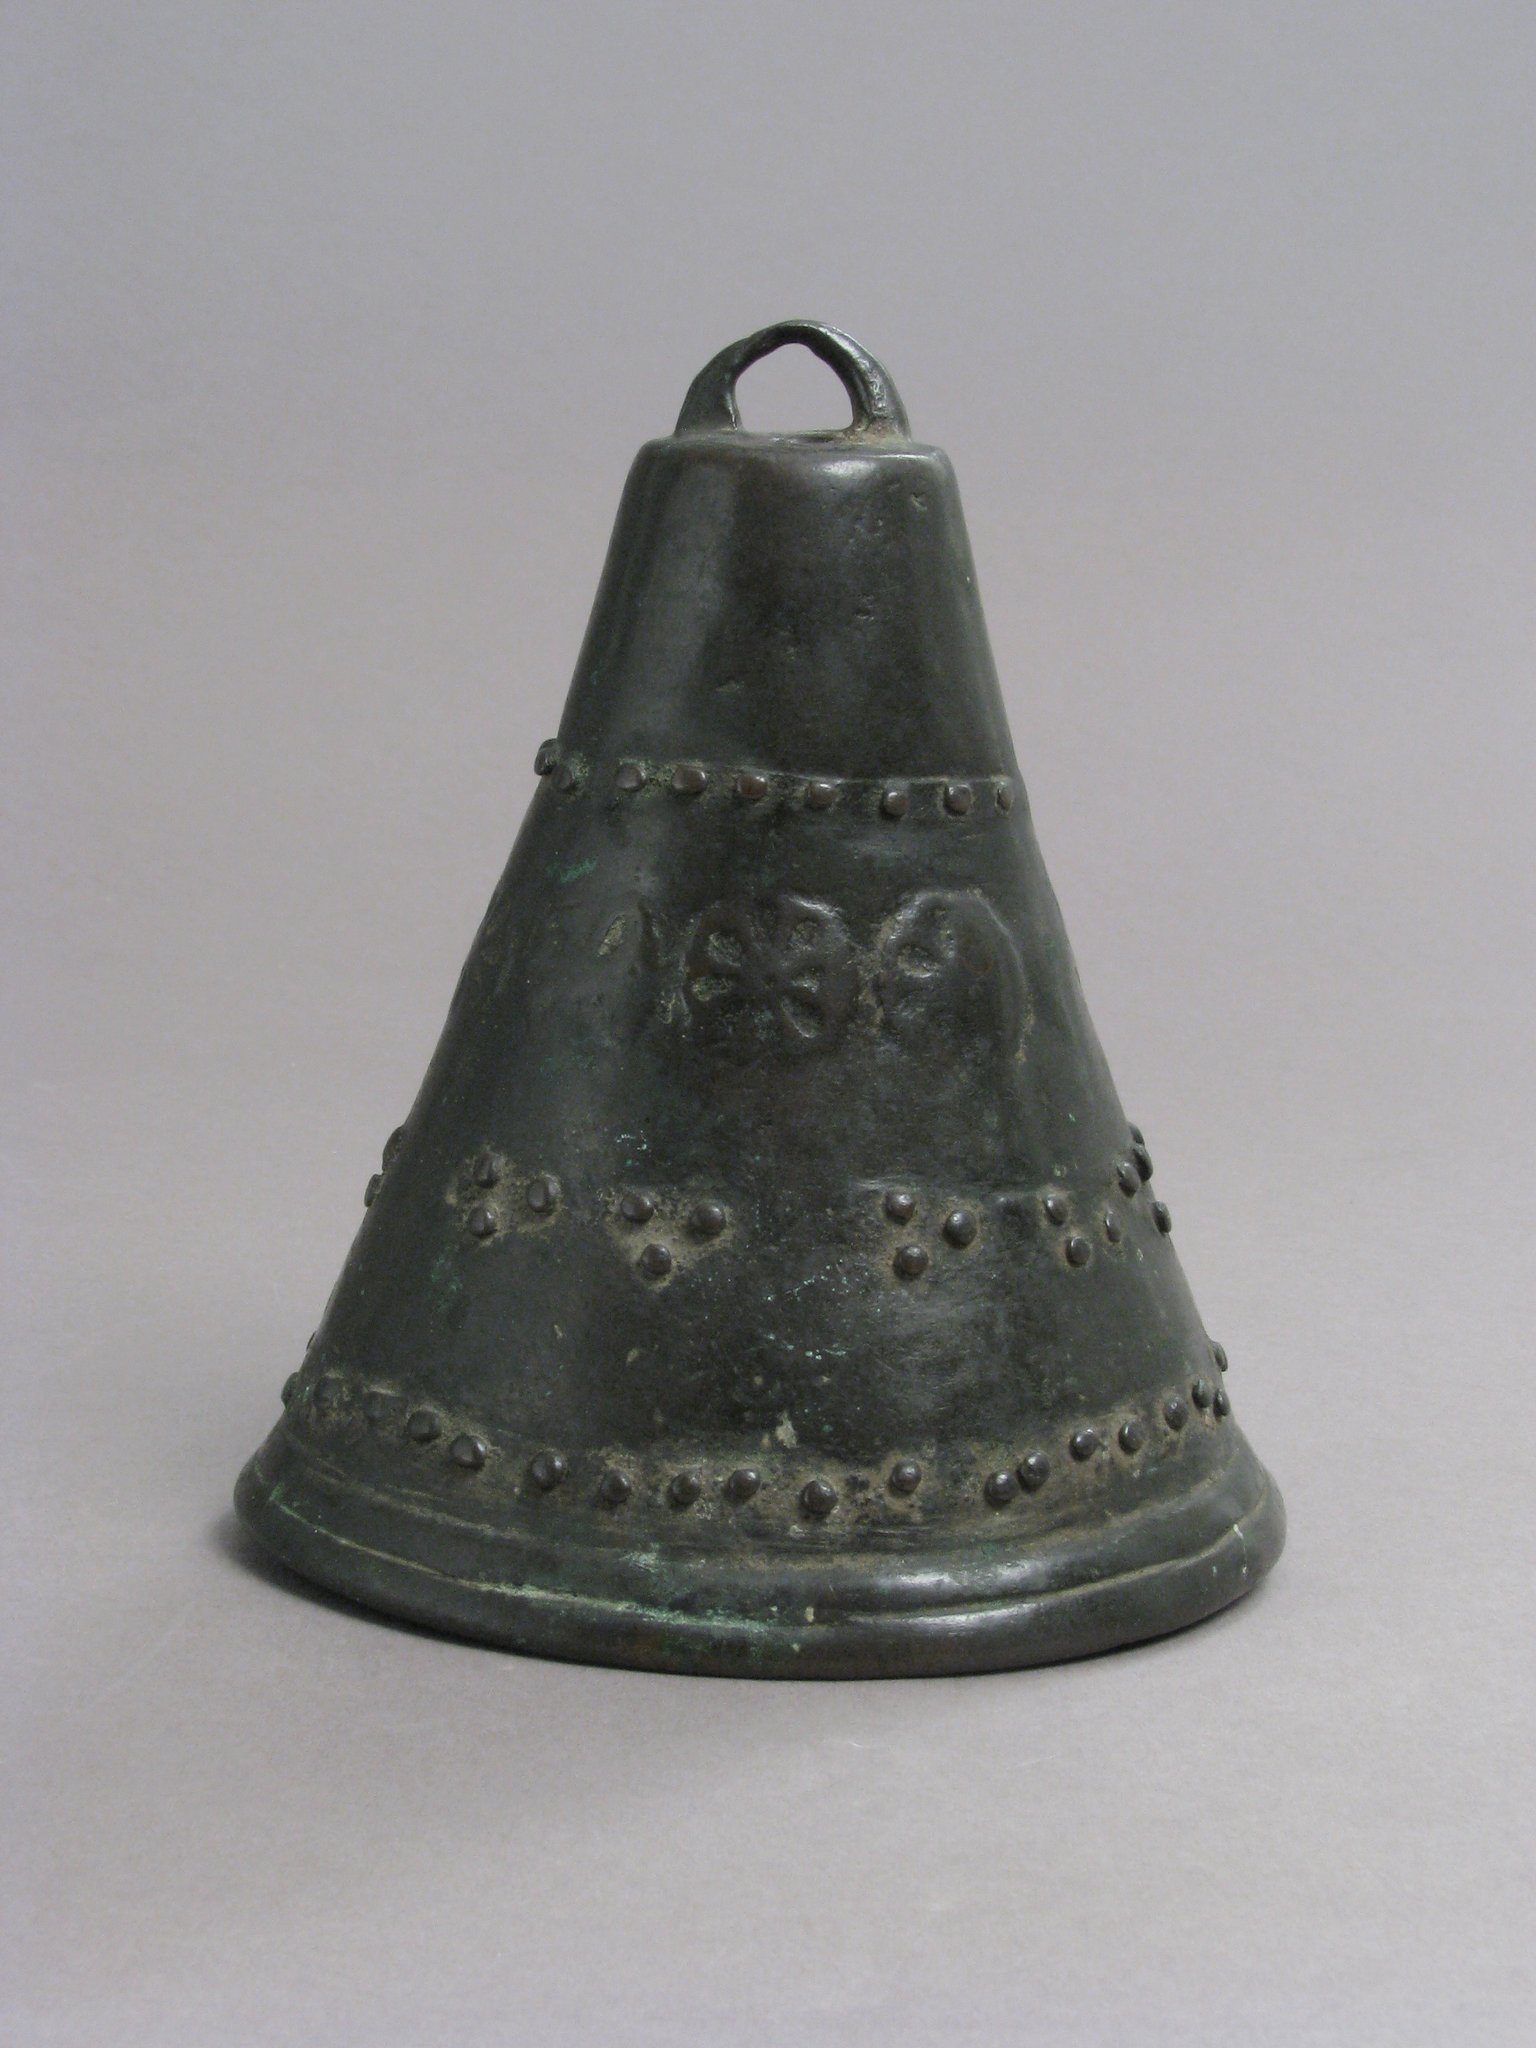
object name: bell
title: Bell, Church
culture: byzantine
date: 901-1200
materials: copper alloy